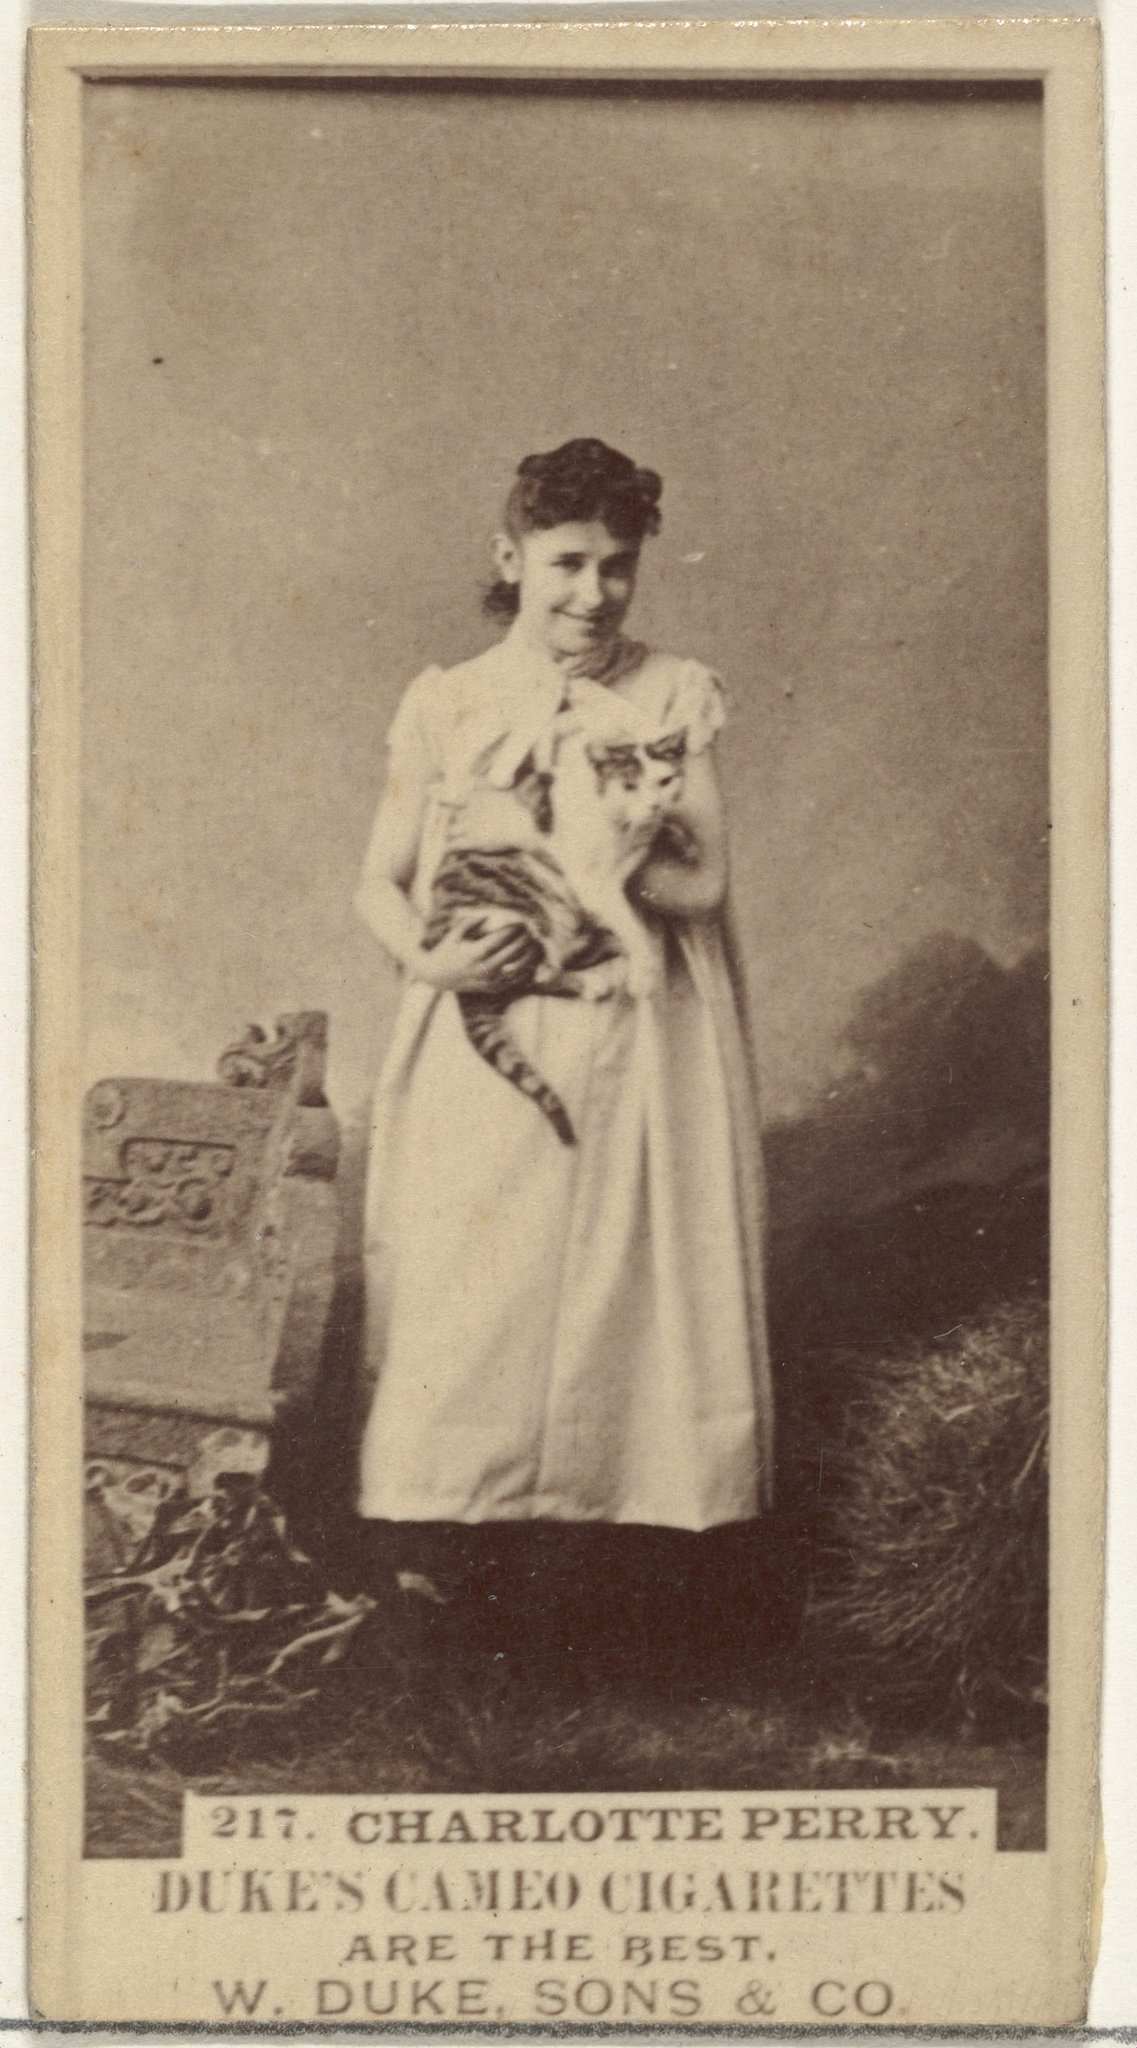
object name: photograph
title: Card Number 217, Charlotte Perry, from the Actors and Actresses series (N145-5) issued by Duke Sons & Co. to promote Cameo Cigarettes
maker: w. duke, sons & co.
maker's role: publisher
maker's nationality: american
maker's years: 1870-1920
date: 1880-1889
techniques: albumen silver print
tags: portraits,women,cats,actresses